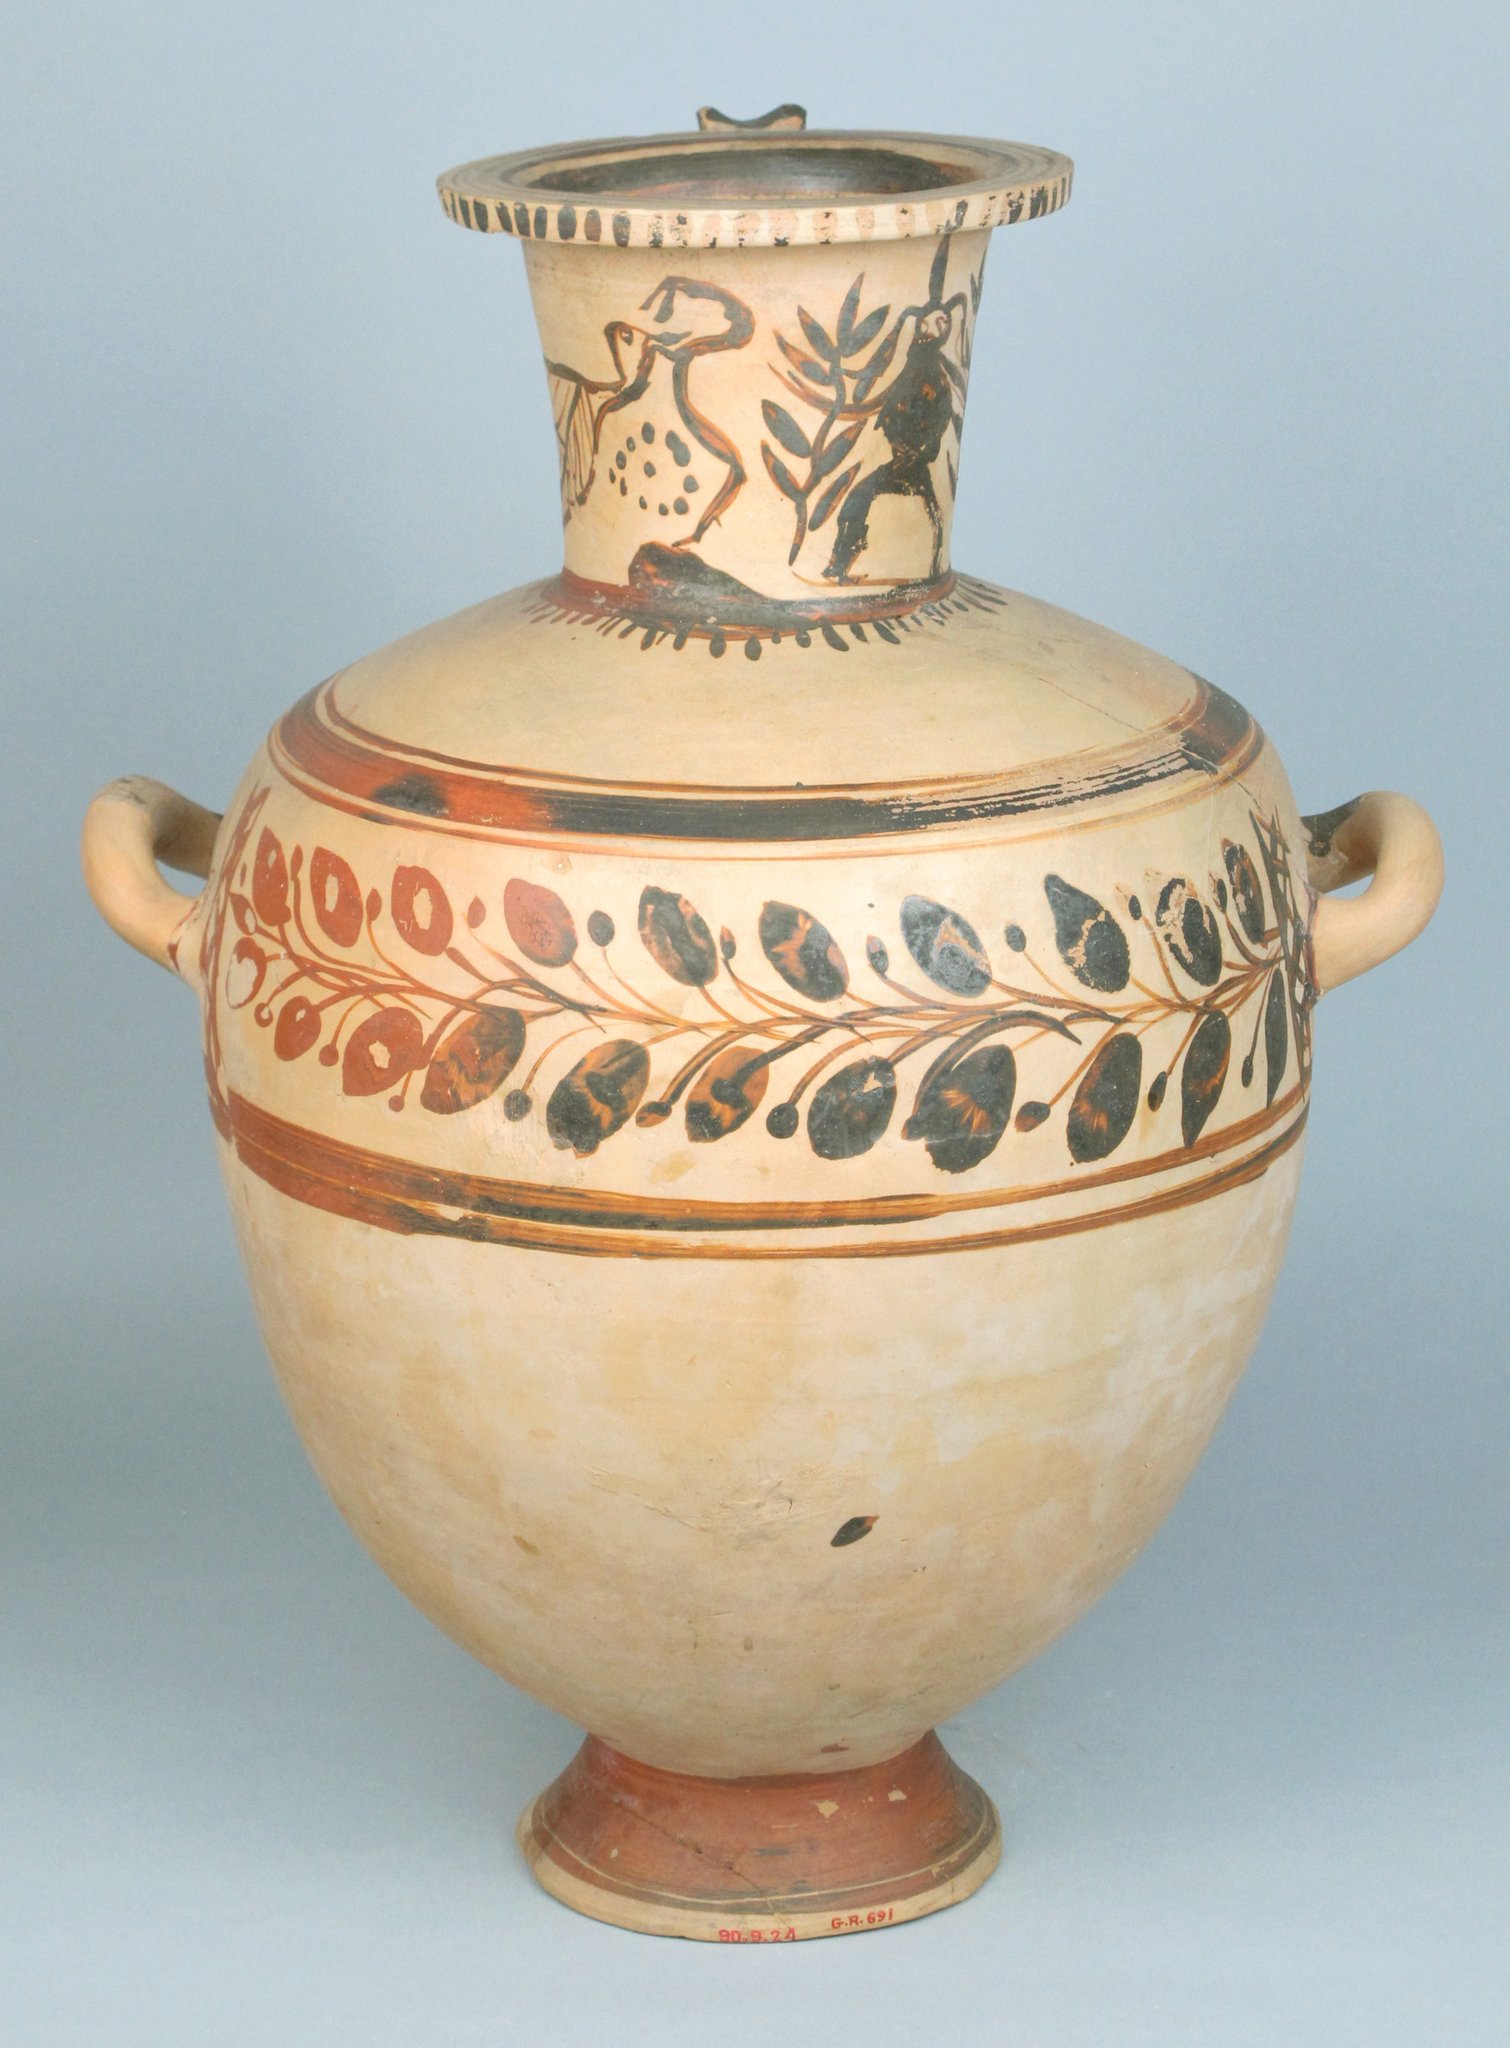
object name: hydria, hadra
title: Terracotta Hadra hydria (water jar)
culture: greek, egyptian, alexandria-hadra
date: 300-201 BCE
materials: terracotta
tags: birds,men